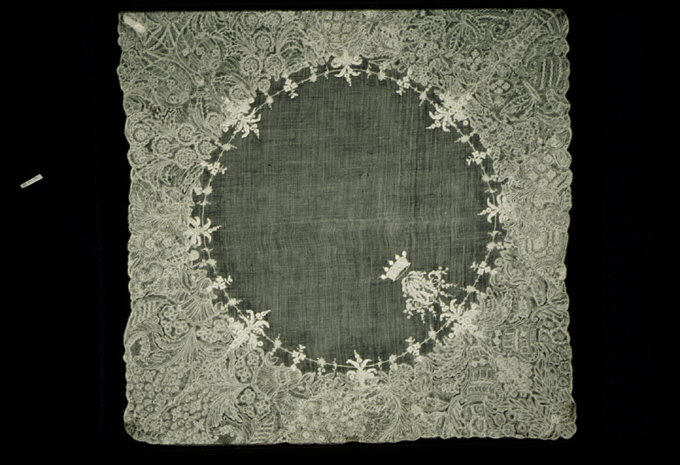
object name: handkerchief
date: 1701-1733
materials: linen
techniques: lace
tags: flowers